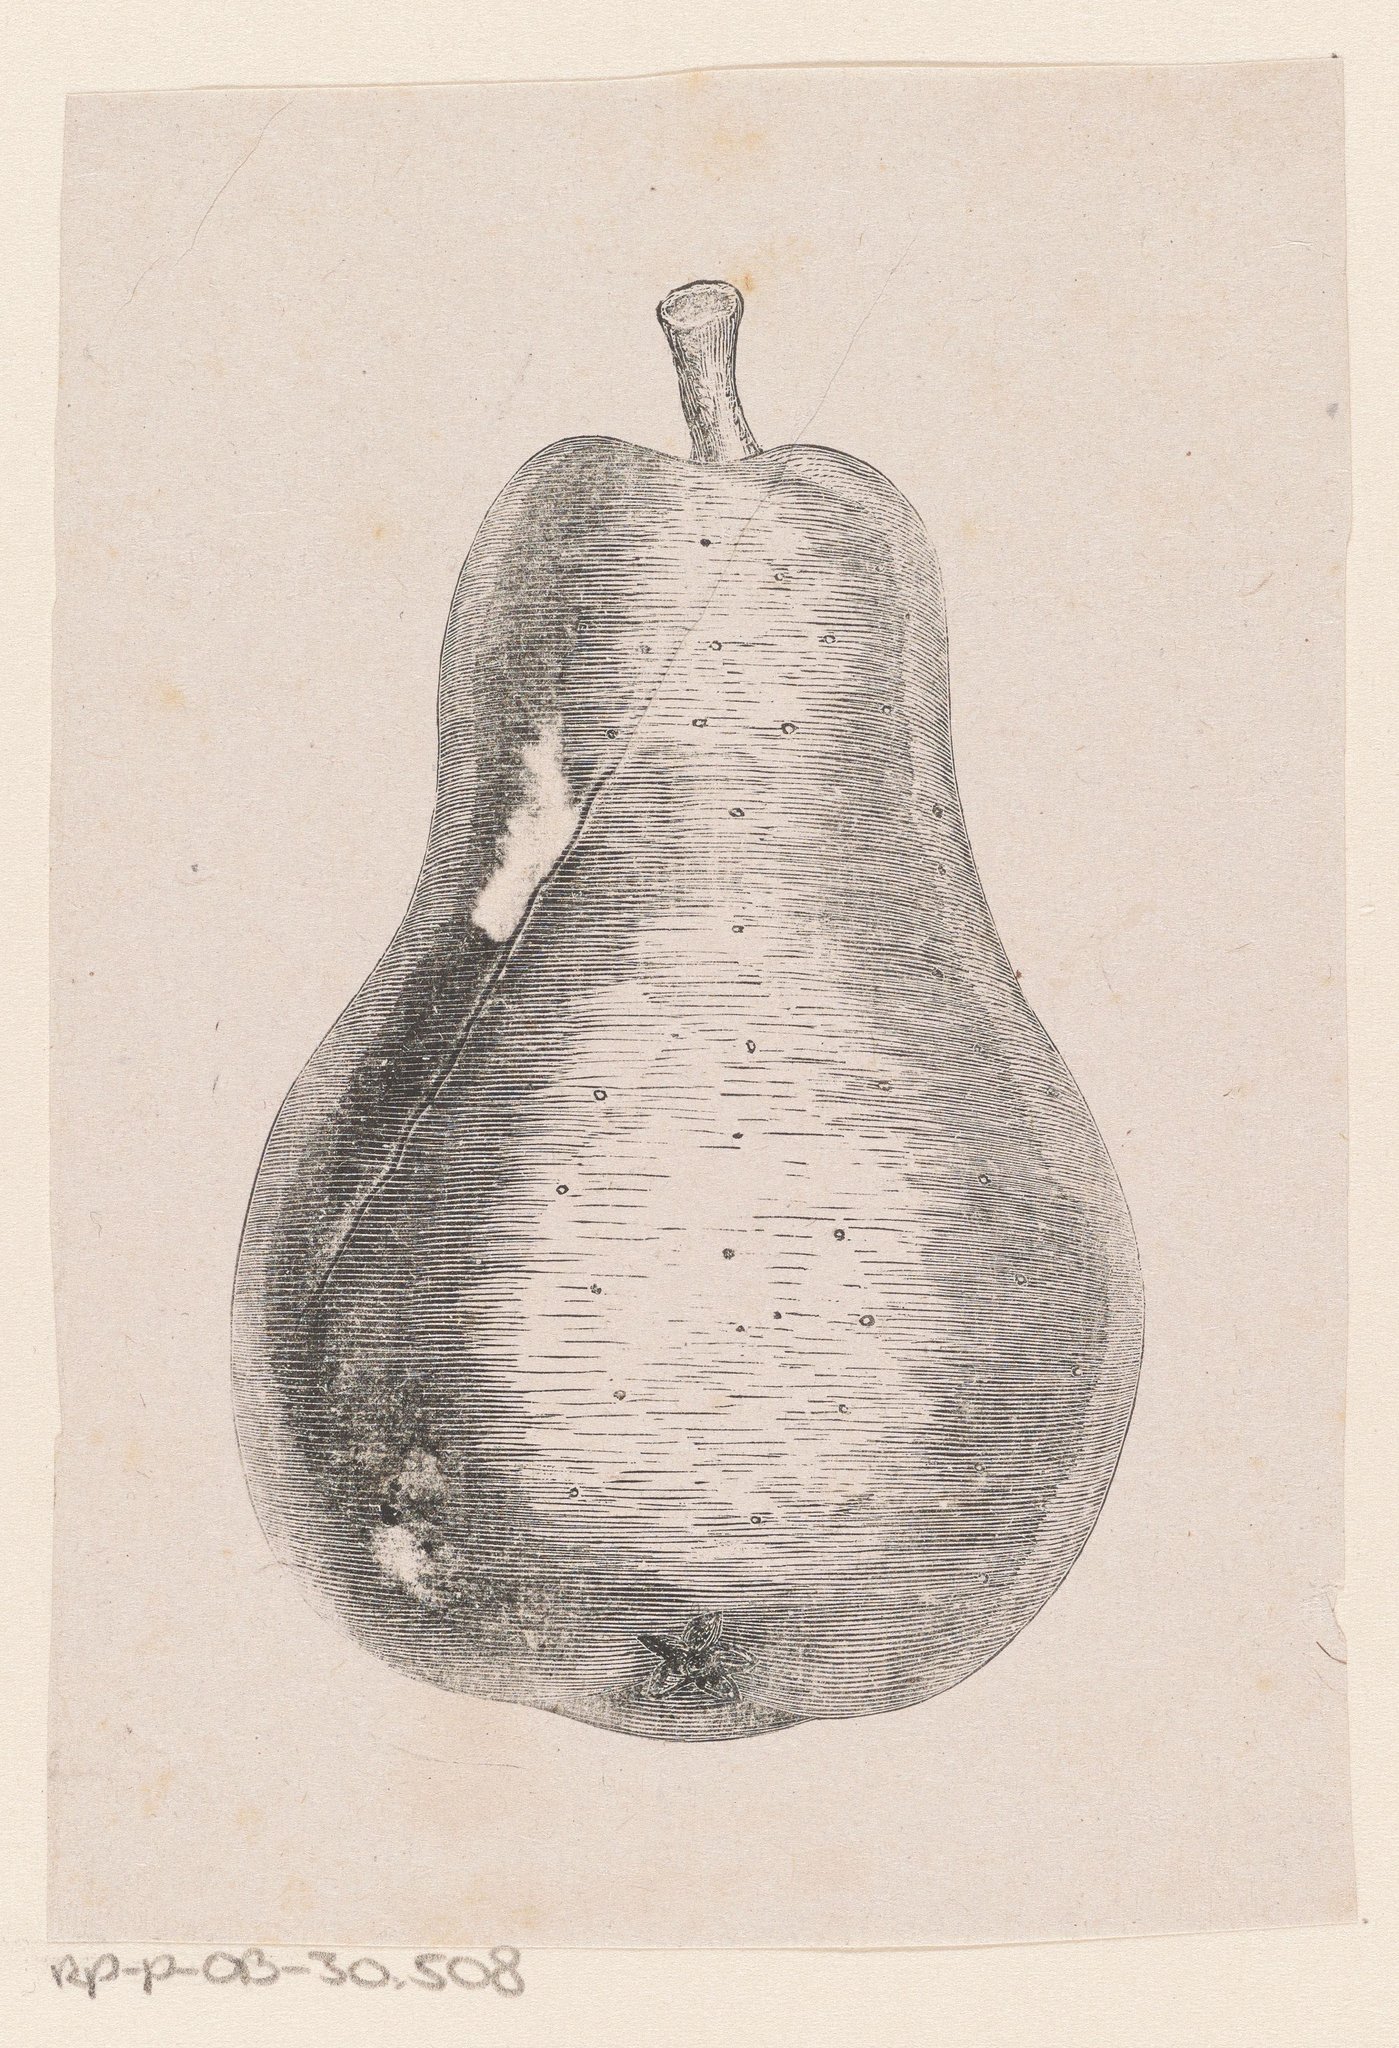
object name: print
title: Aangetaste peer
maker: isaac weissenbruch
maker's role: print maker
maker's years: 1826-1912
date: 1836-1912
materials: paper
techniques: engraving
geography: netherlands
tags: fruits: pear